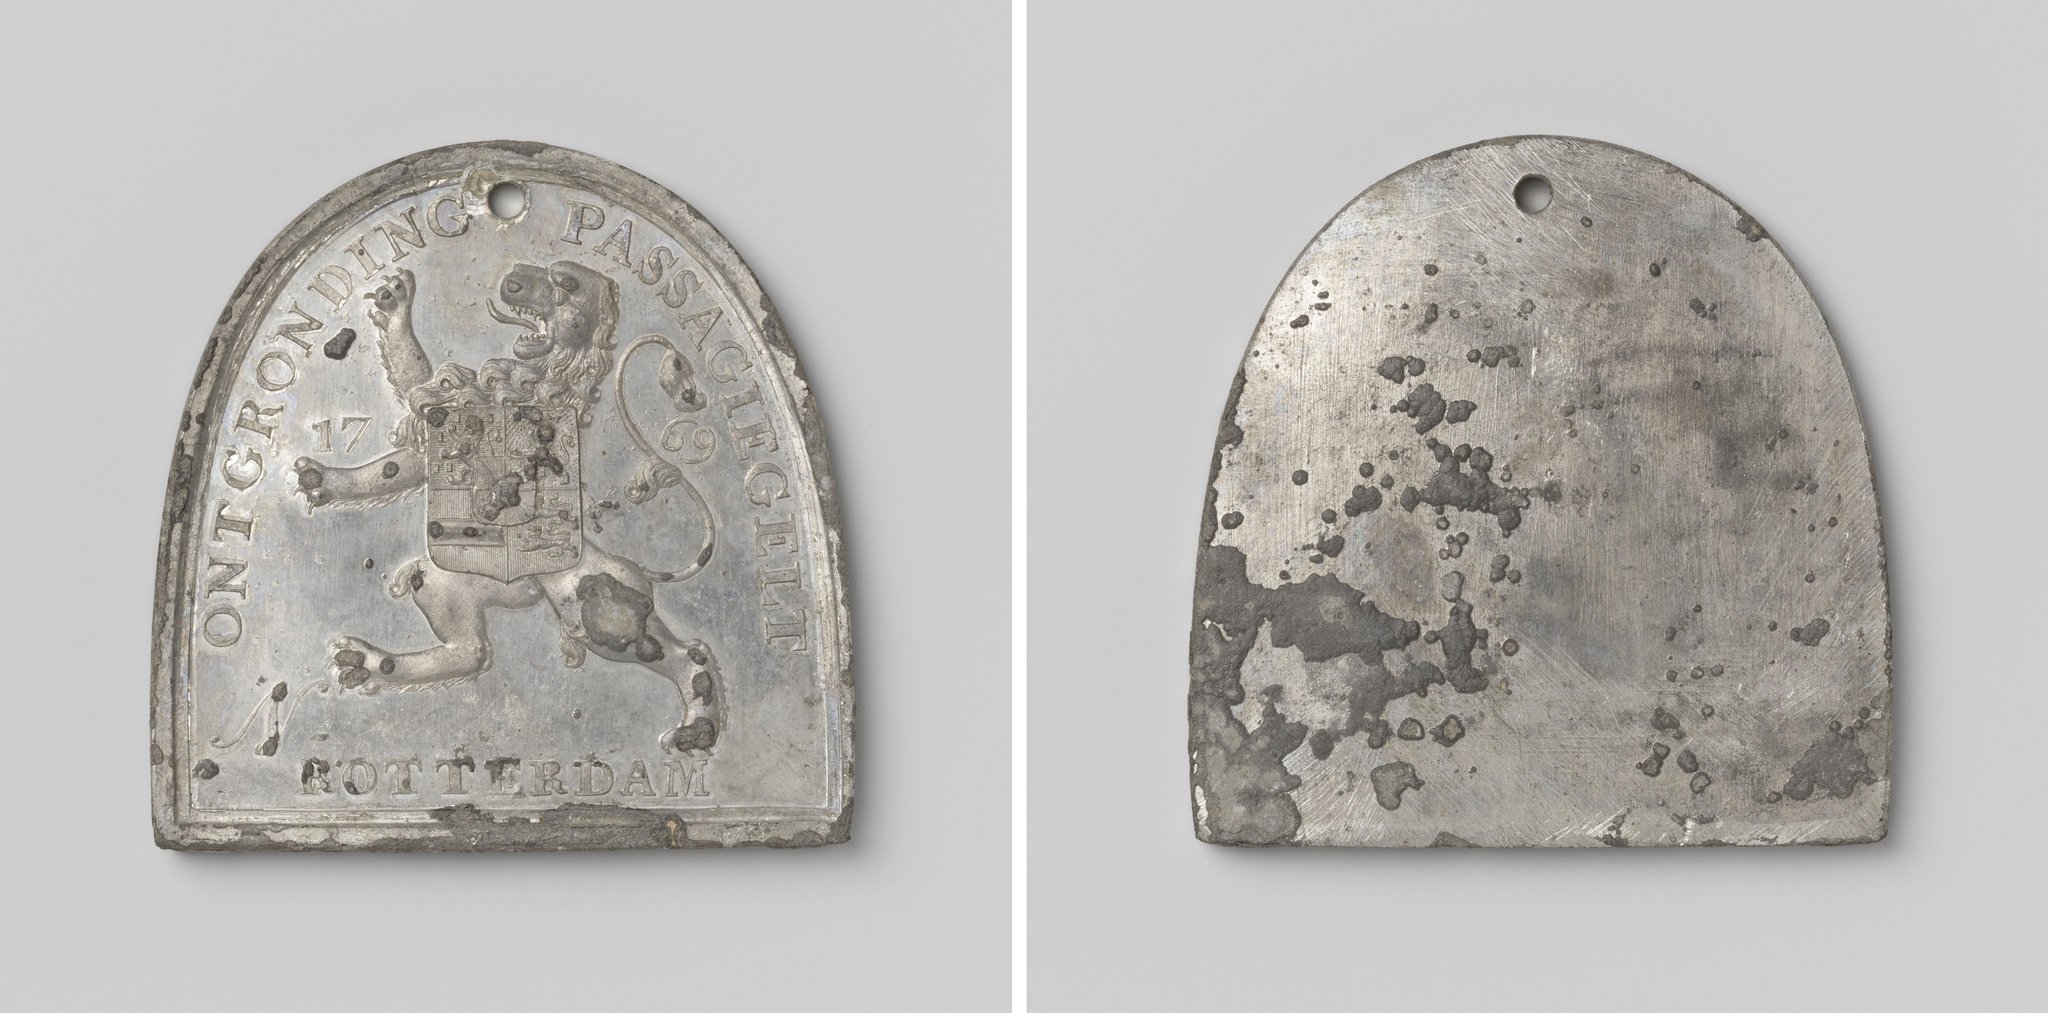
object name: identification medal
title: Ontgronding te Rotterdam, penning bedoeld als bewijs voor turfdragers, -vullers of -tonners om turf in te mogen voeren uit de nieuw ontgronde venen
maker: Anonymous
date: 1769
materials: lead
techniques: casting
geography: rotterdam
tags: rotterdam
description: Eenzijdige loden penning met ronde boven- en rechthoekige onderzijde, en gat erin. Voorzijde: staande leeuw met wapenschild op borst tussen jaartal binnen omschrift. Keerzijde: blanco.